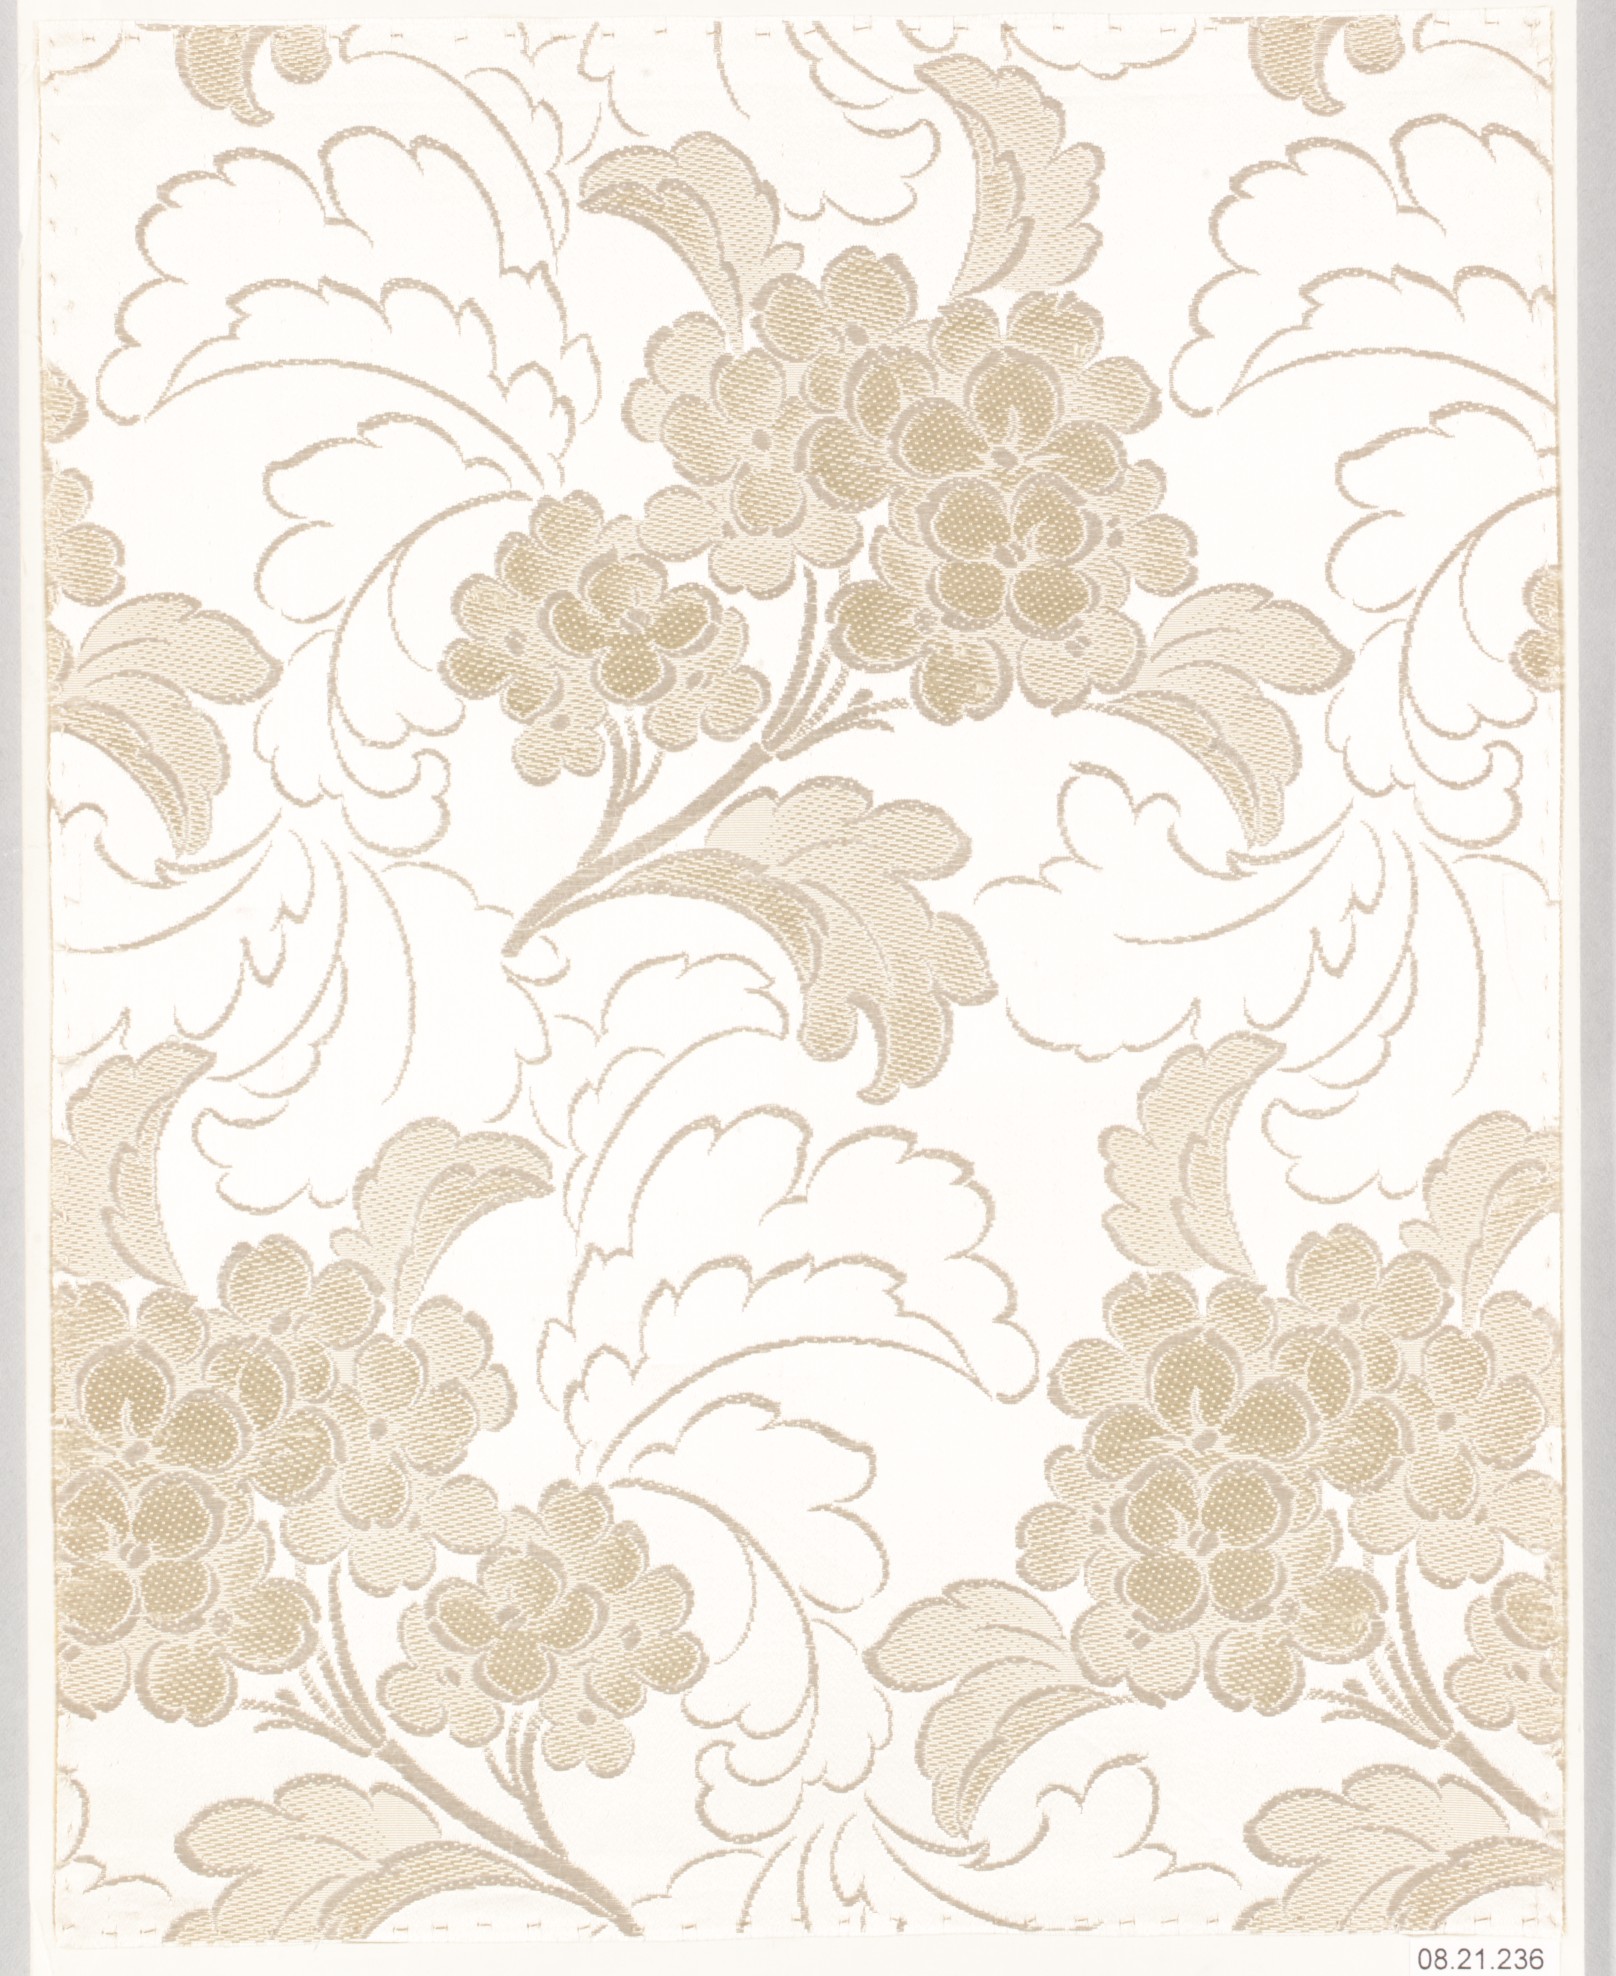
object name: textile sample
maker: Anonymous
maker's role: designer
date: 1900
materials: silk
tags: leaves